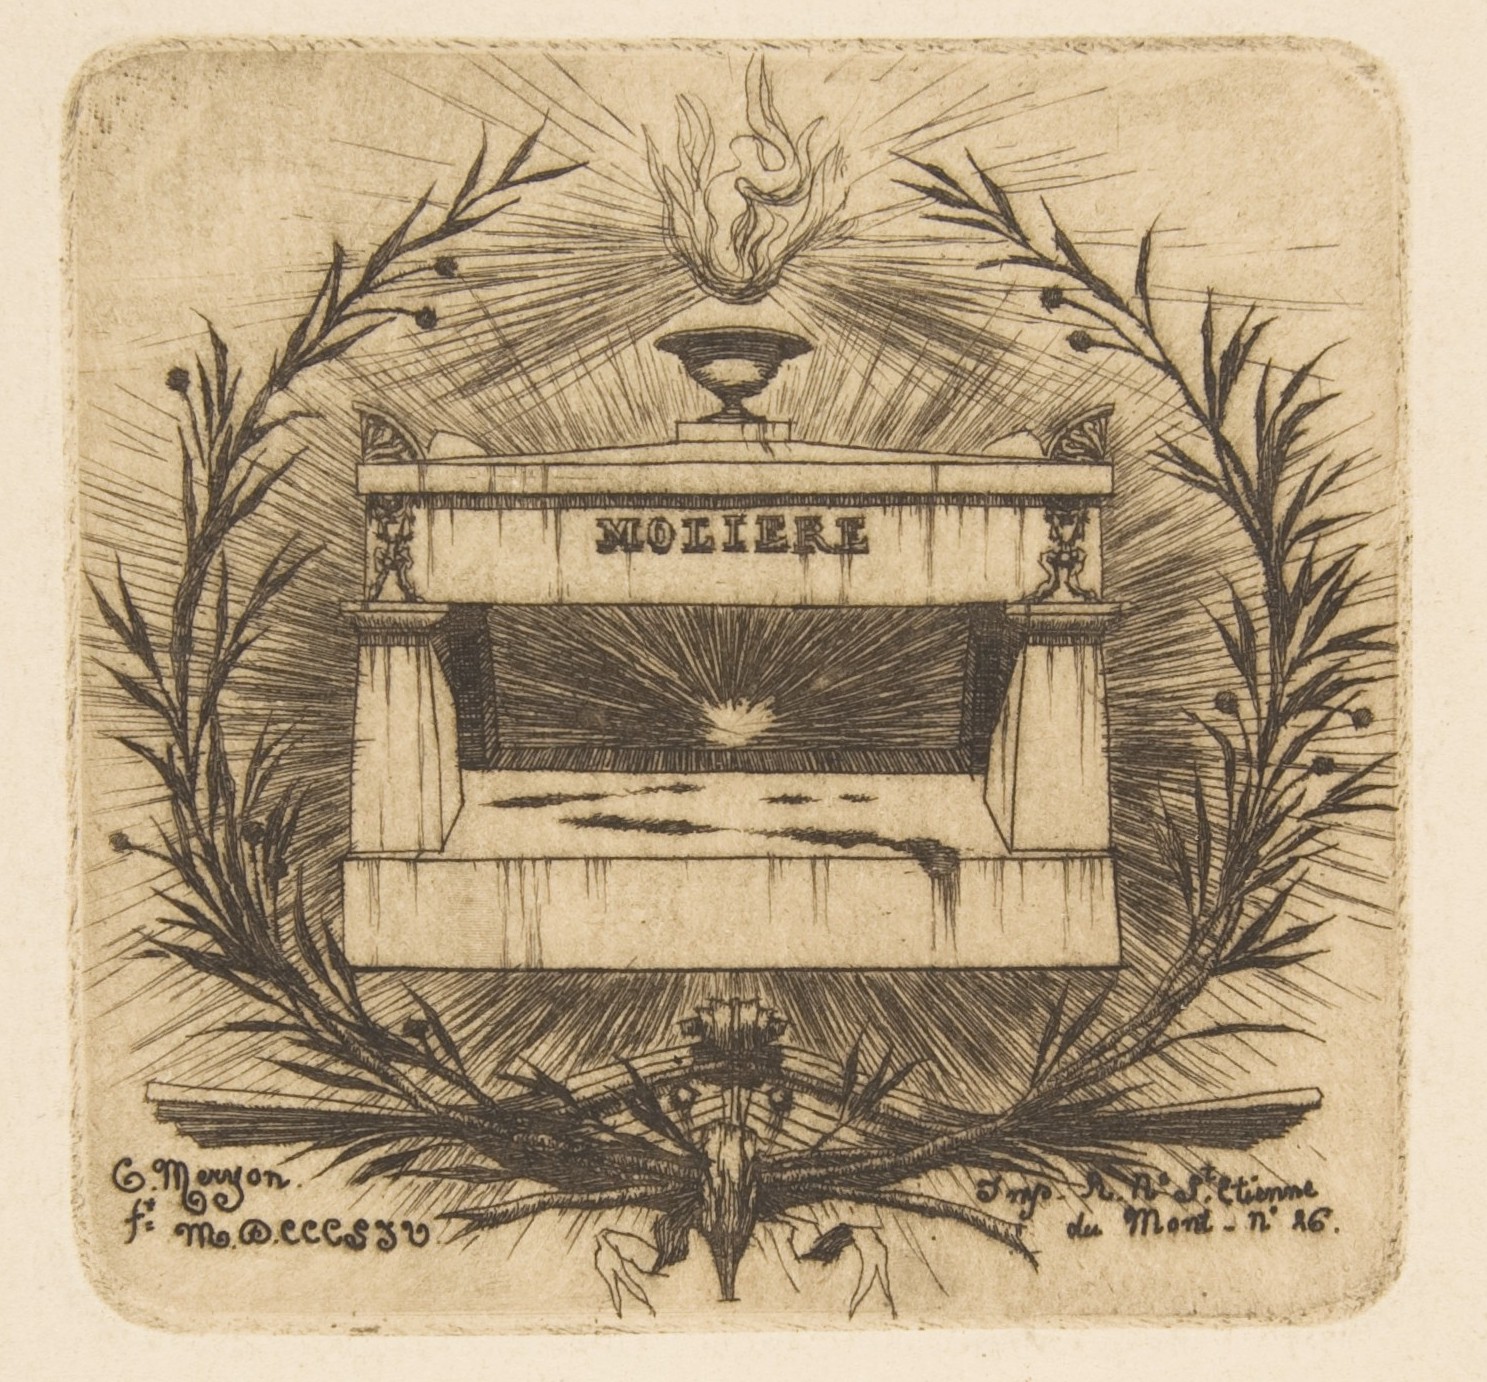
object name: print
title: Molière's Tomb, Père-Lachaise Cemetery, Paris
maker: charles meryon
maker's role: artist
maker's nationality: french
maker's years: 1821-1868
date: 1854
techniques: etching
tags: tombs